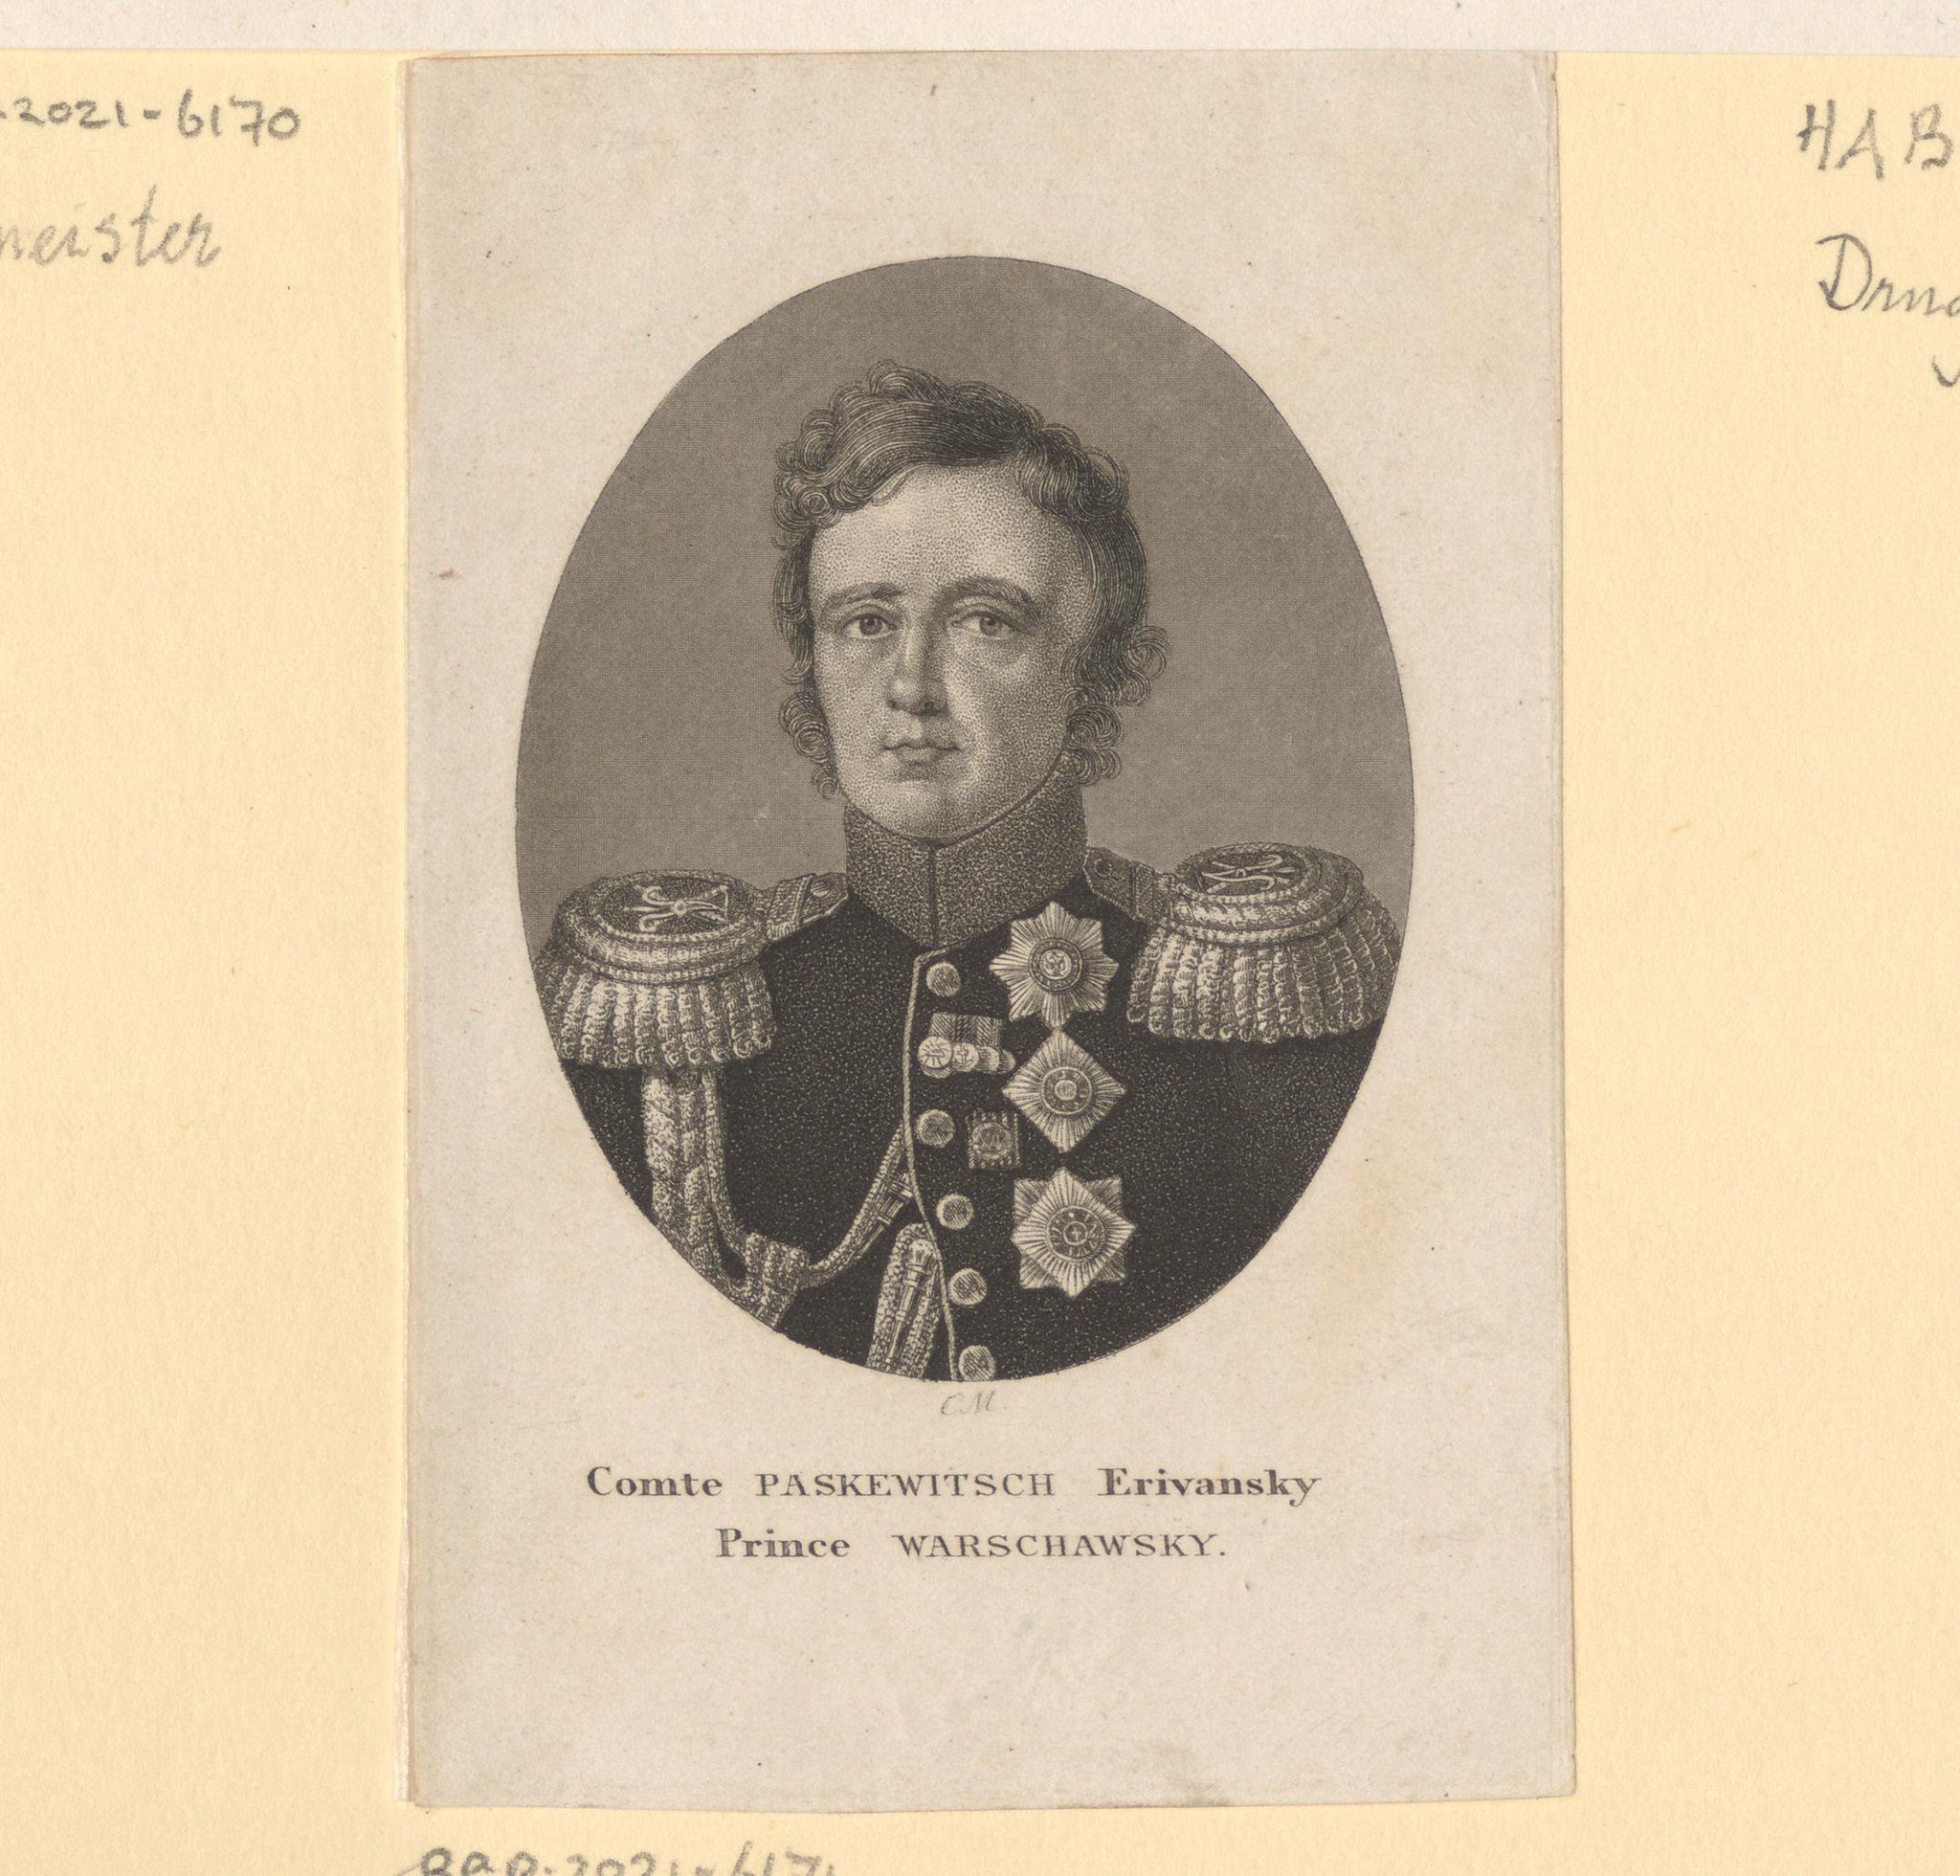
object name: print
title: Portret van Ivan Paskevitsj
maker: Anonymous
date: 1838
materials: paper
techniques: engraving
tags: earl, adult man, historical persons, (military) uniforms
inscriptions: initials: ‘C.M.’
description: Prent mogelijk uit: Almanach de Gotha: annuaire généalogique, diplomatique et statistique. Gotha: Justus Perthes, 1838.